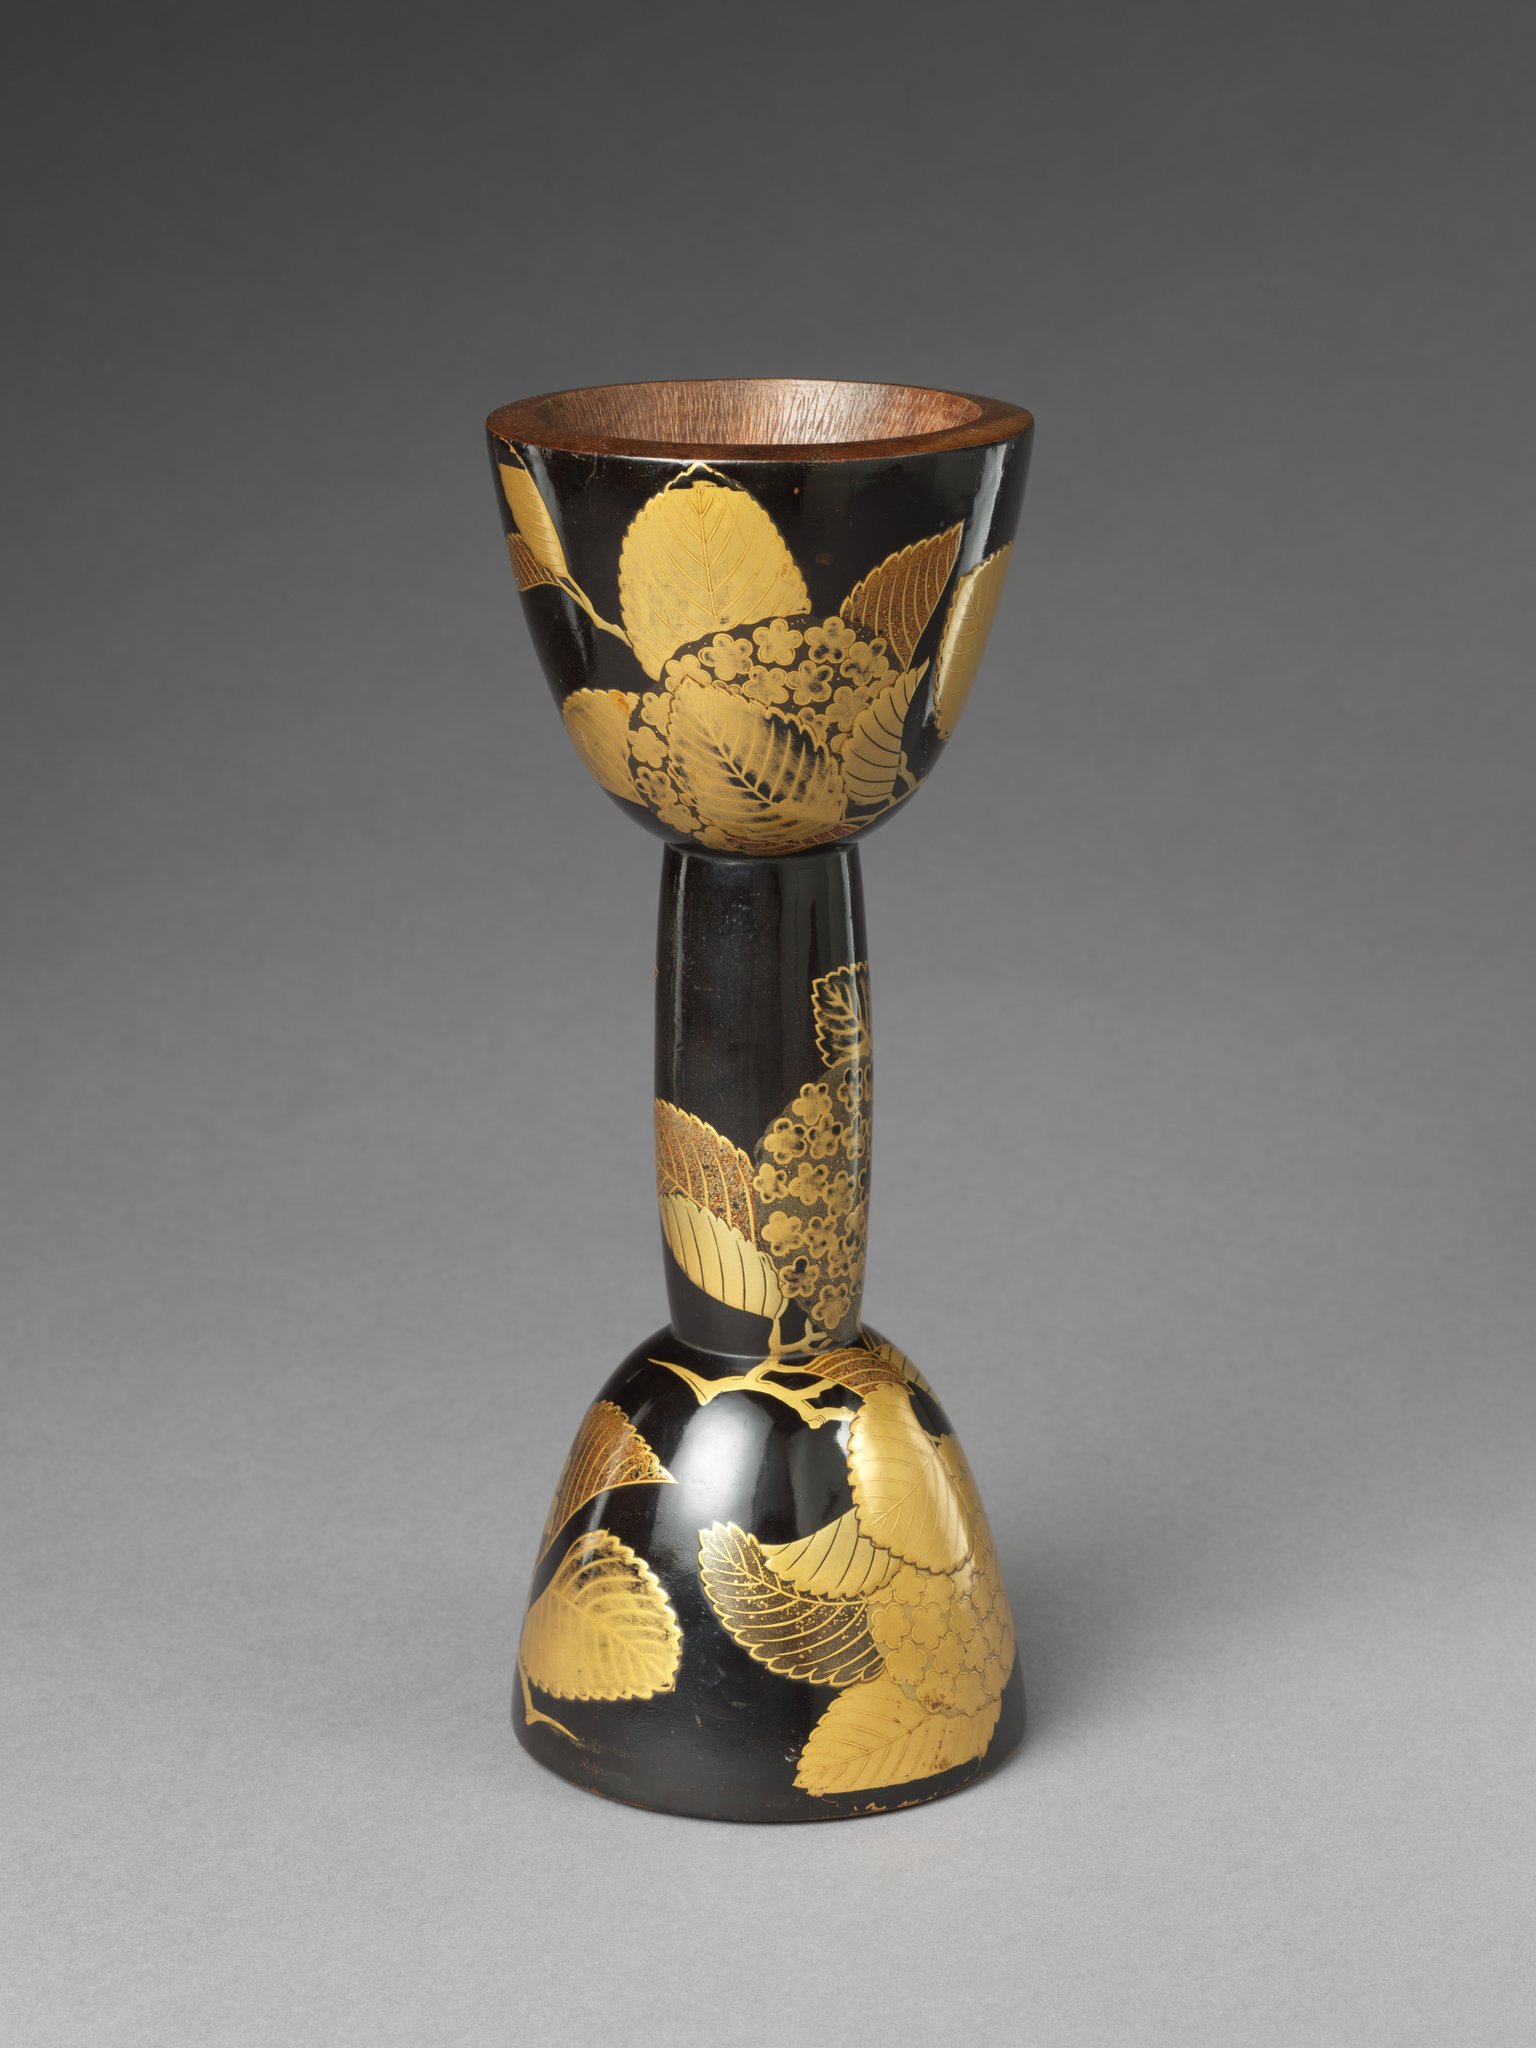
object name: drum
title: Small Shoulder Drum (Kotsuzumi) with Hydrangeas for Noh Performance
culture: japanese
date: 1701-1800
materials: gold, silver, wood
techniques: hiramakie, lacquer